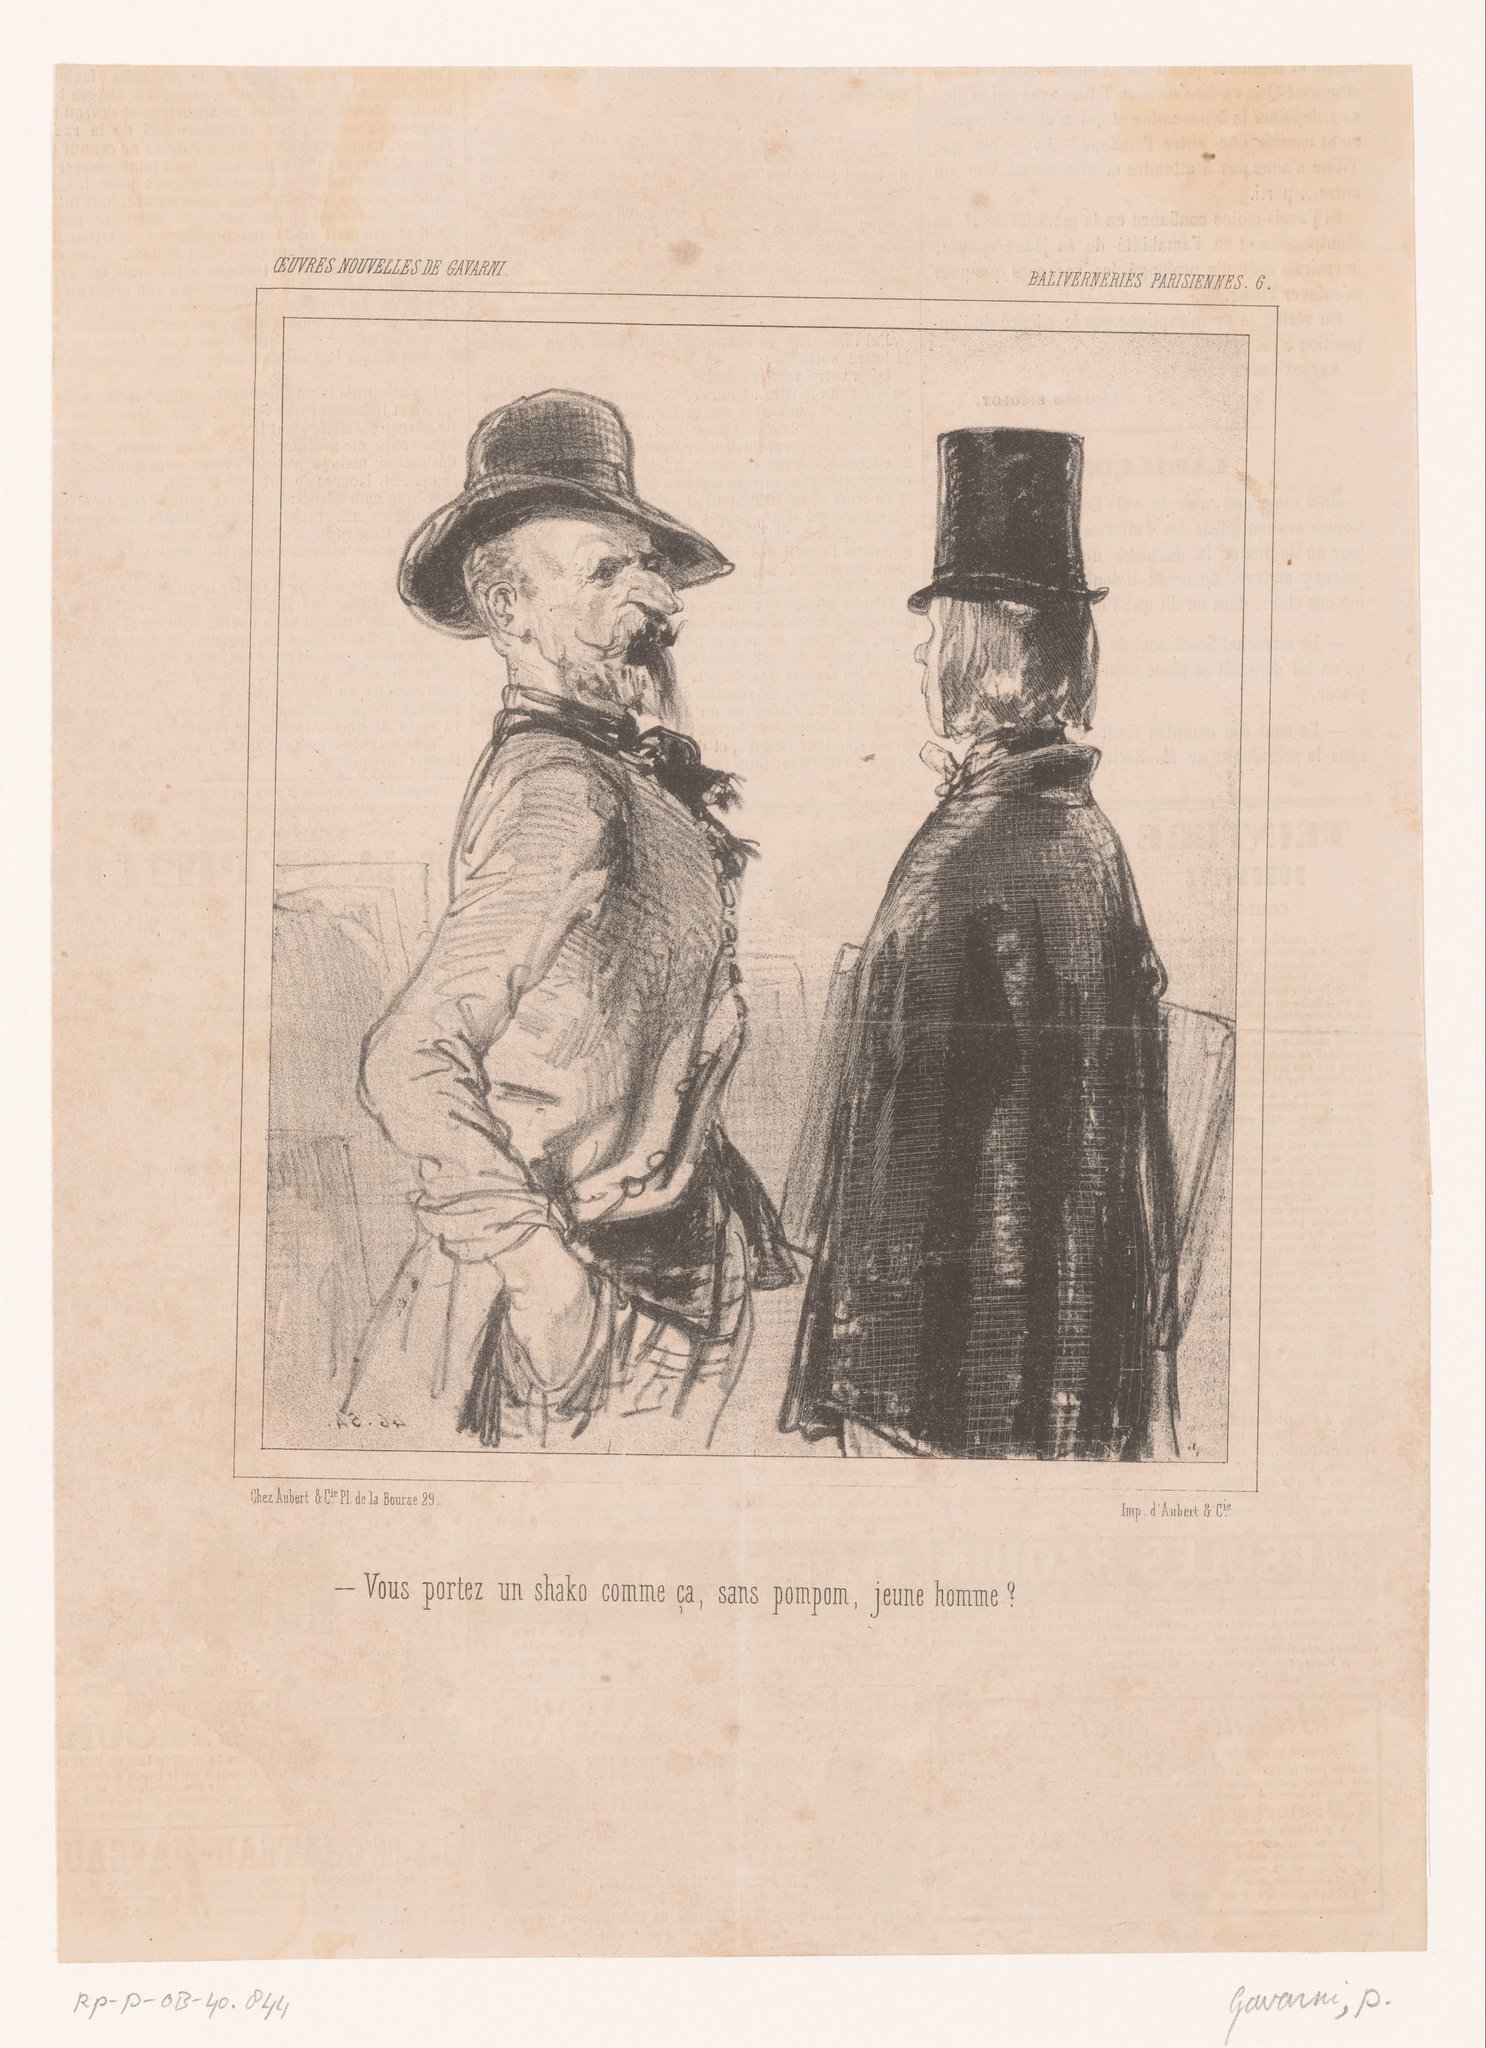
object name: print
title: Vous portez un shako comme ça, sans pompom, jeune homme?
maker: paul gavarni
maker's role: draughtsman, print maker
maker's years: 1804-1866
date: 1846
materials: paper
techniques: lithograph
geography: paris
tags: old man, head-gear: hat, artist in non-work situation, apprentice ~ guild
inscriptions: collector's mark: Lugt 2228a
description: Prent gebruikt voor: Le Charivari, 6 november 1846.